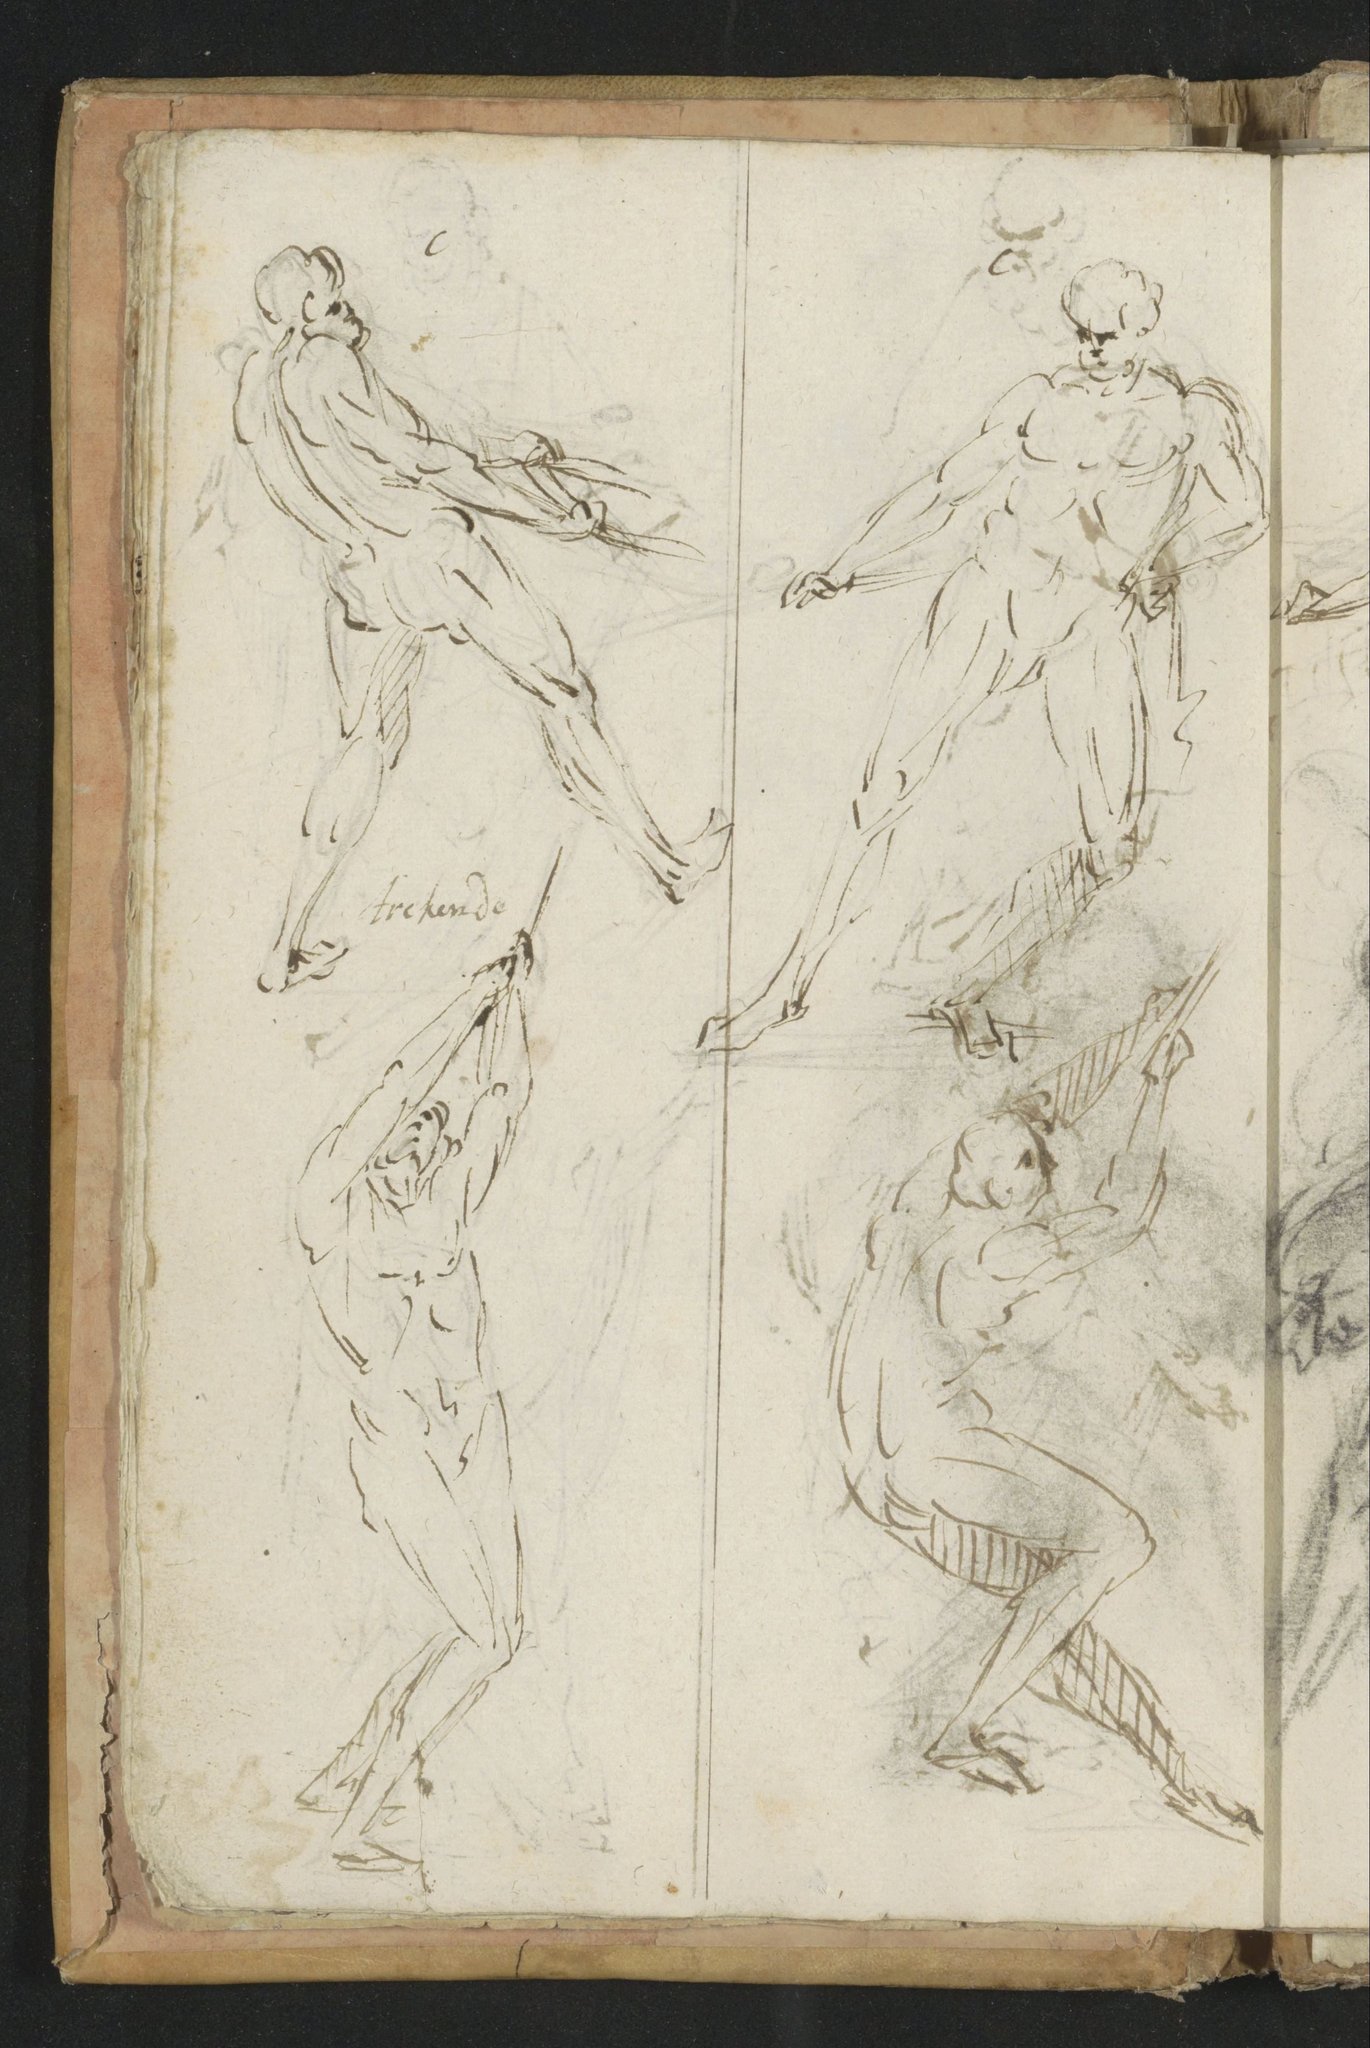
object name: sketchbook leaf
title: Vier naakte mannen die lasten trekken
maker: Anonymous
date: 1658-1728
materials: ink, paper, pencil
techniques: pen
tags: drawing, pulling something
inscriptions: annotation: ‘c c/ trekende’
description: Blad 6 verso uit een schetsboek met 33 bladen.